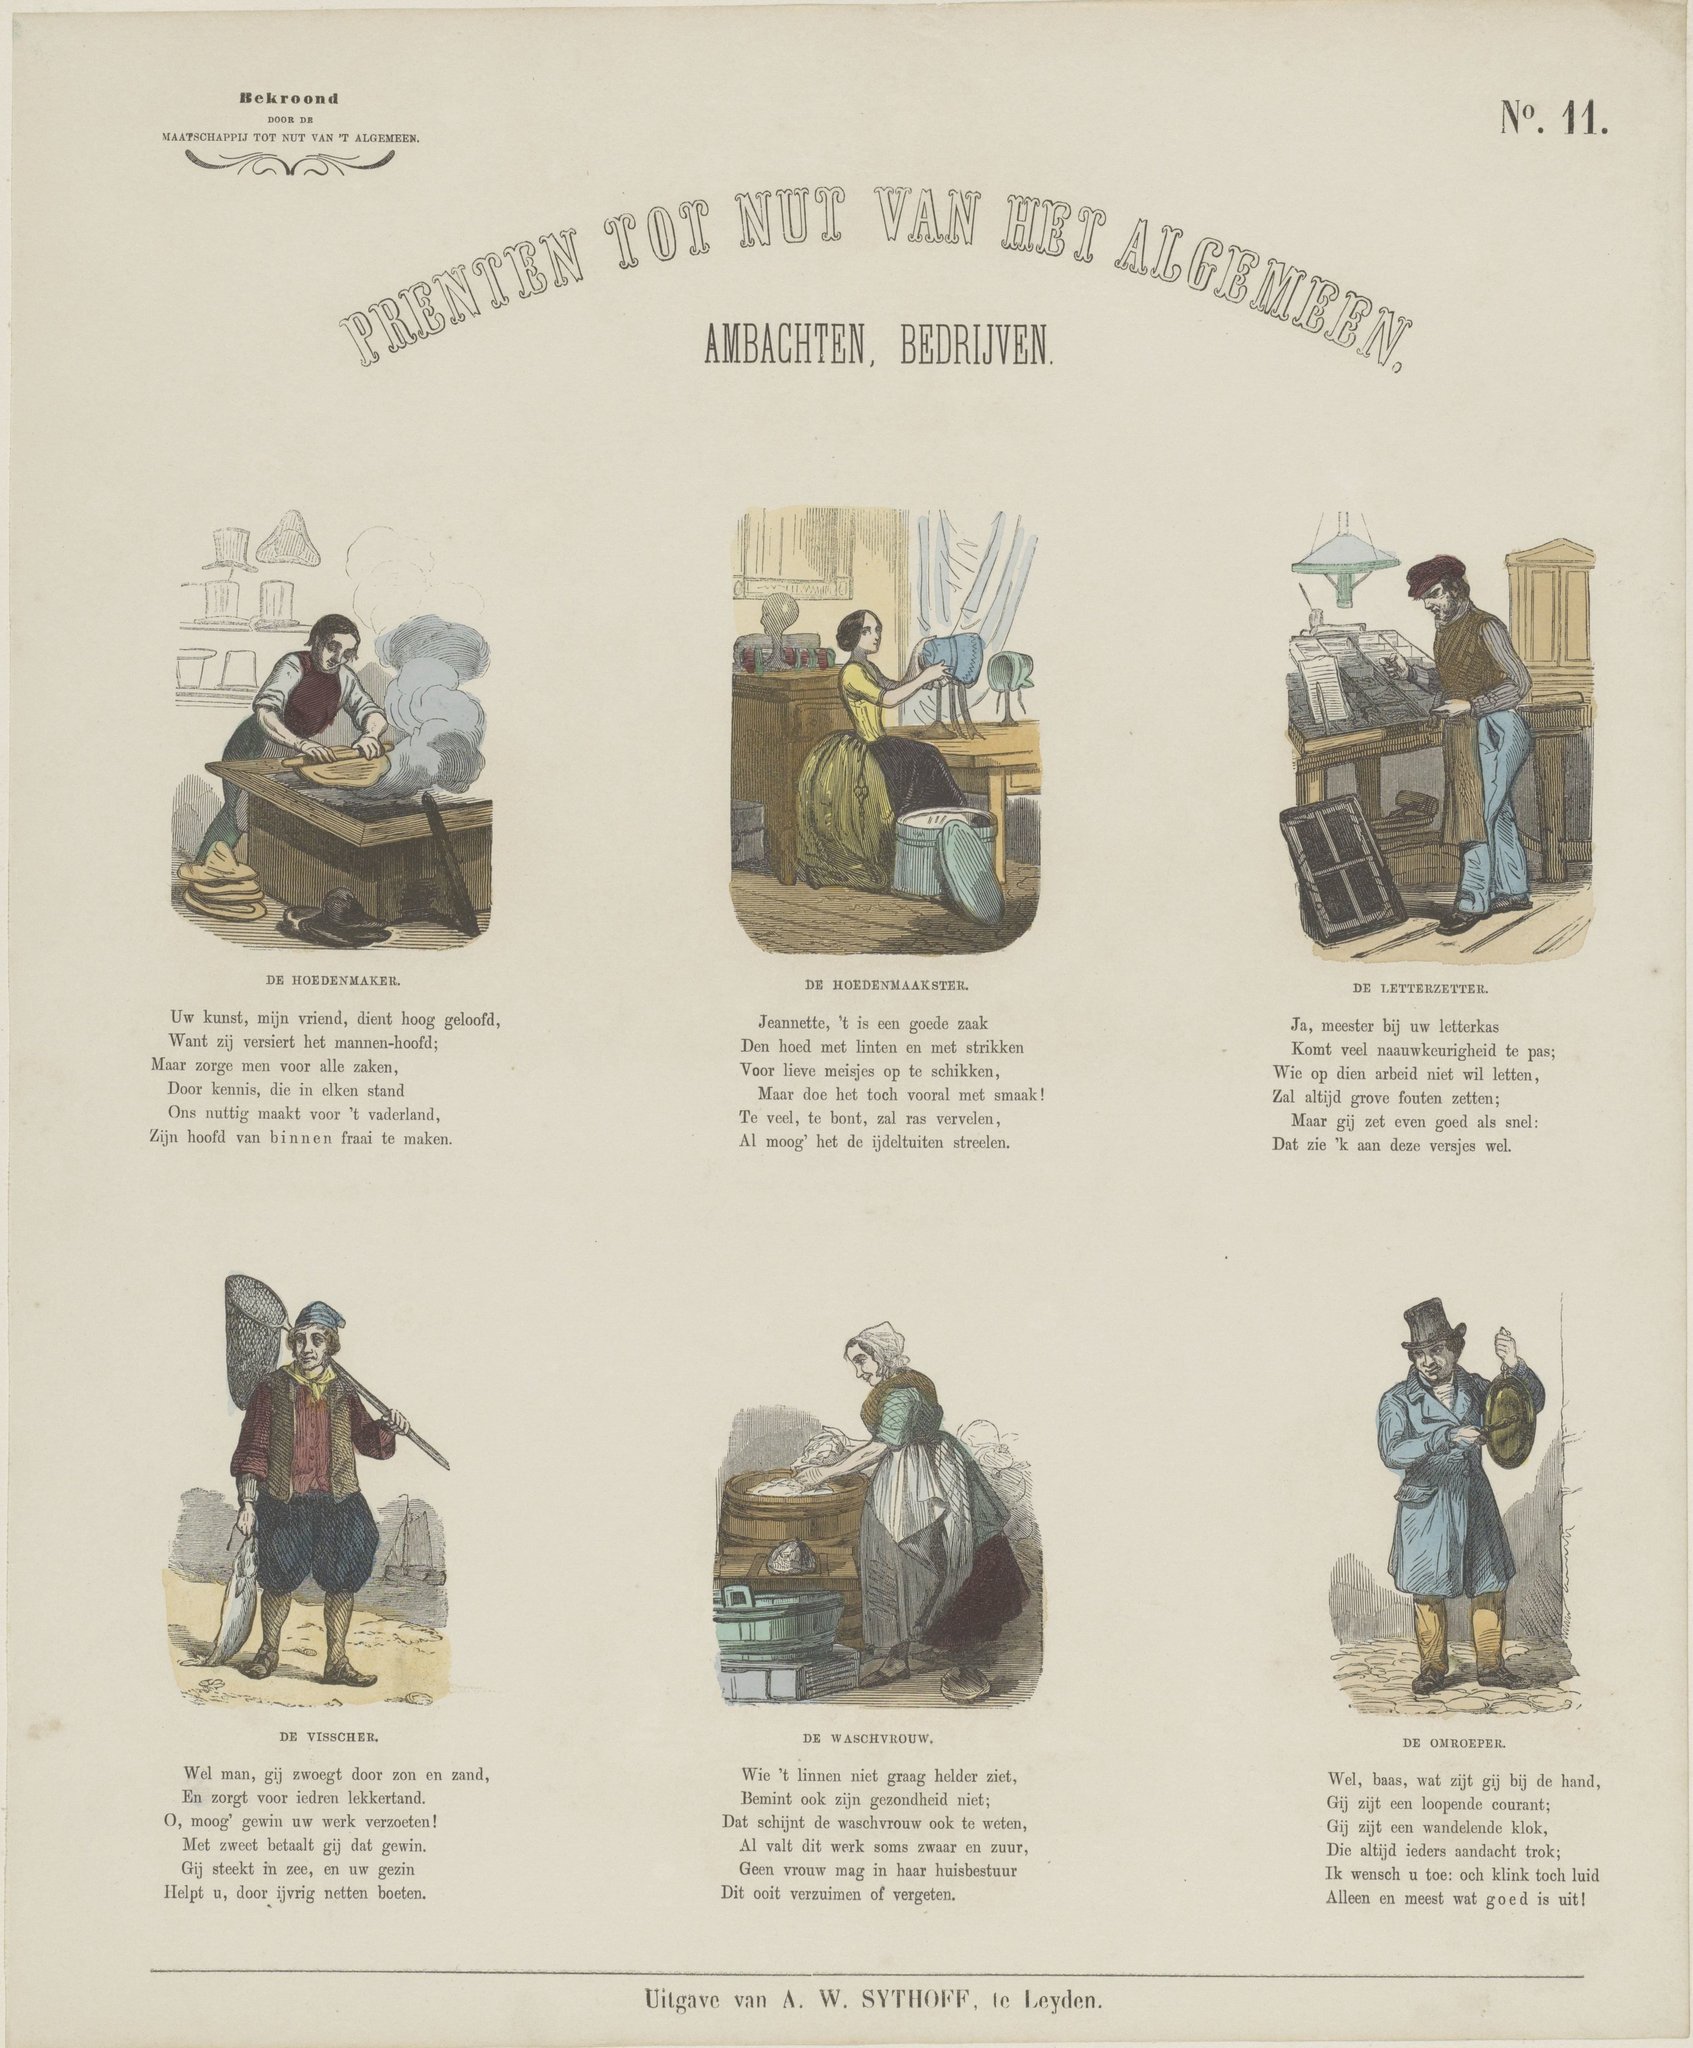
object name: print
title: Ambachten, bedrijven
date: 1861-1929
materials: paper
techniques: colour, letterpress printing, engraving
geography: leiden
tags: craft-production, skilled handiwork, crafts and industries, fisherman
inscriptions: collector's mark: Lugt 2760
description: Blad met 6 voorstellingen van ambachtlieden en beroepen, zoals een hoedenmaker, een letterzetter, een visser en een omroeper. Onder elke afbeelding een titel en een vers. Genummerd rechtsboven: No. 11. Linksboven: Bekroond door de Maatschappij tot Nut van 't Algemeen.